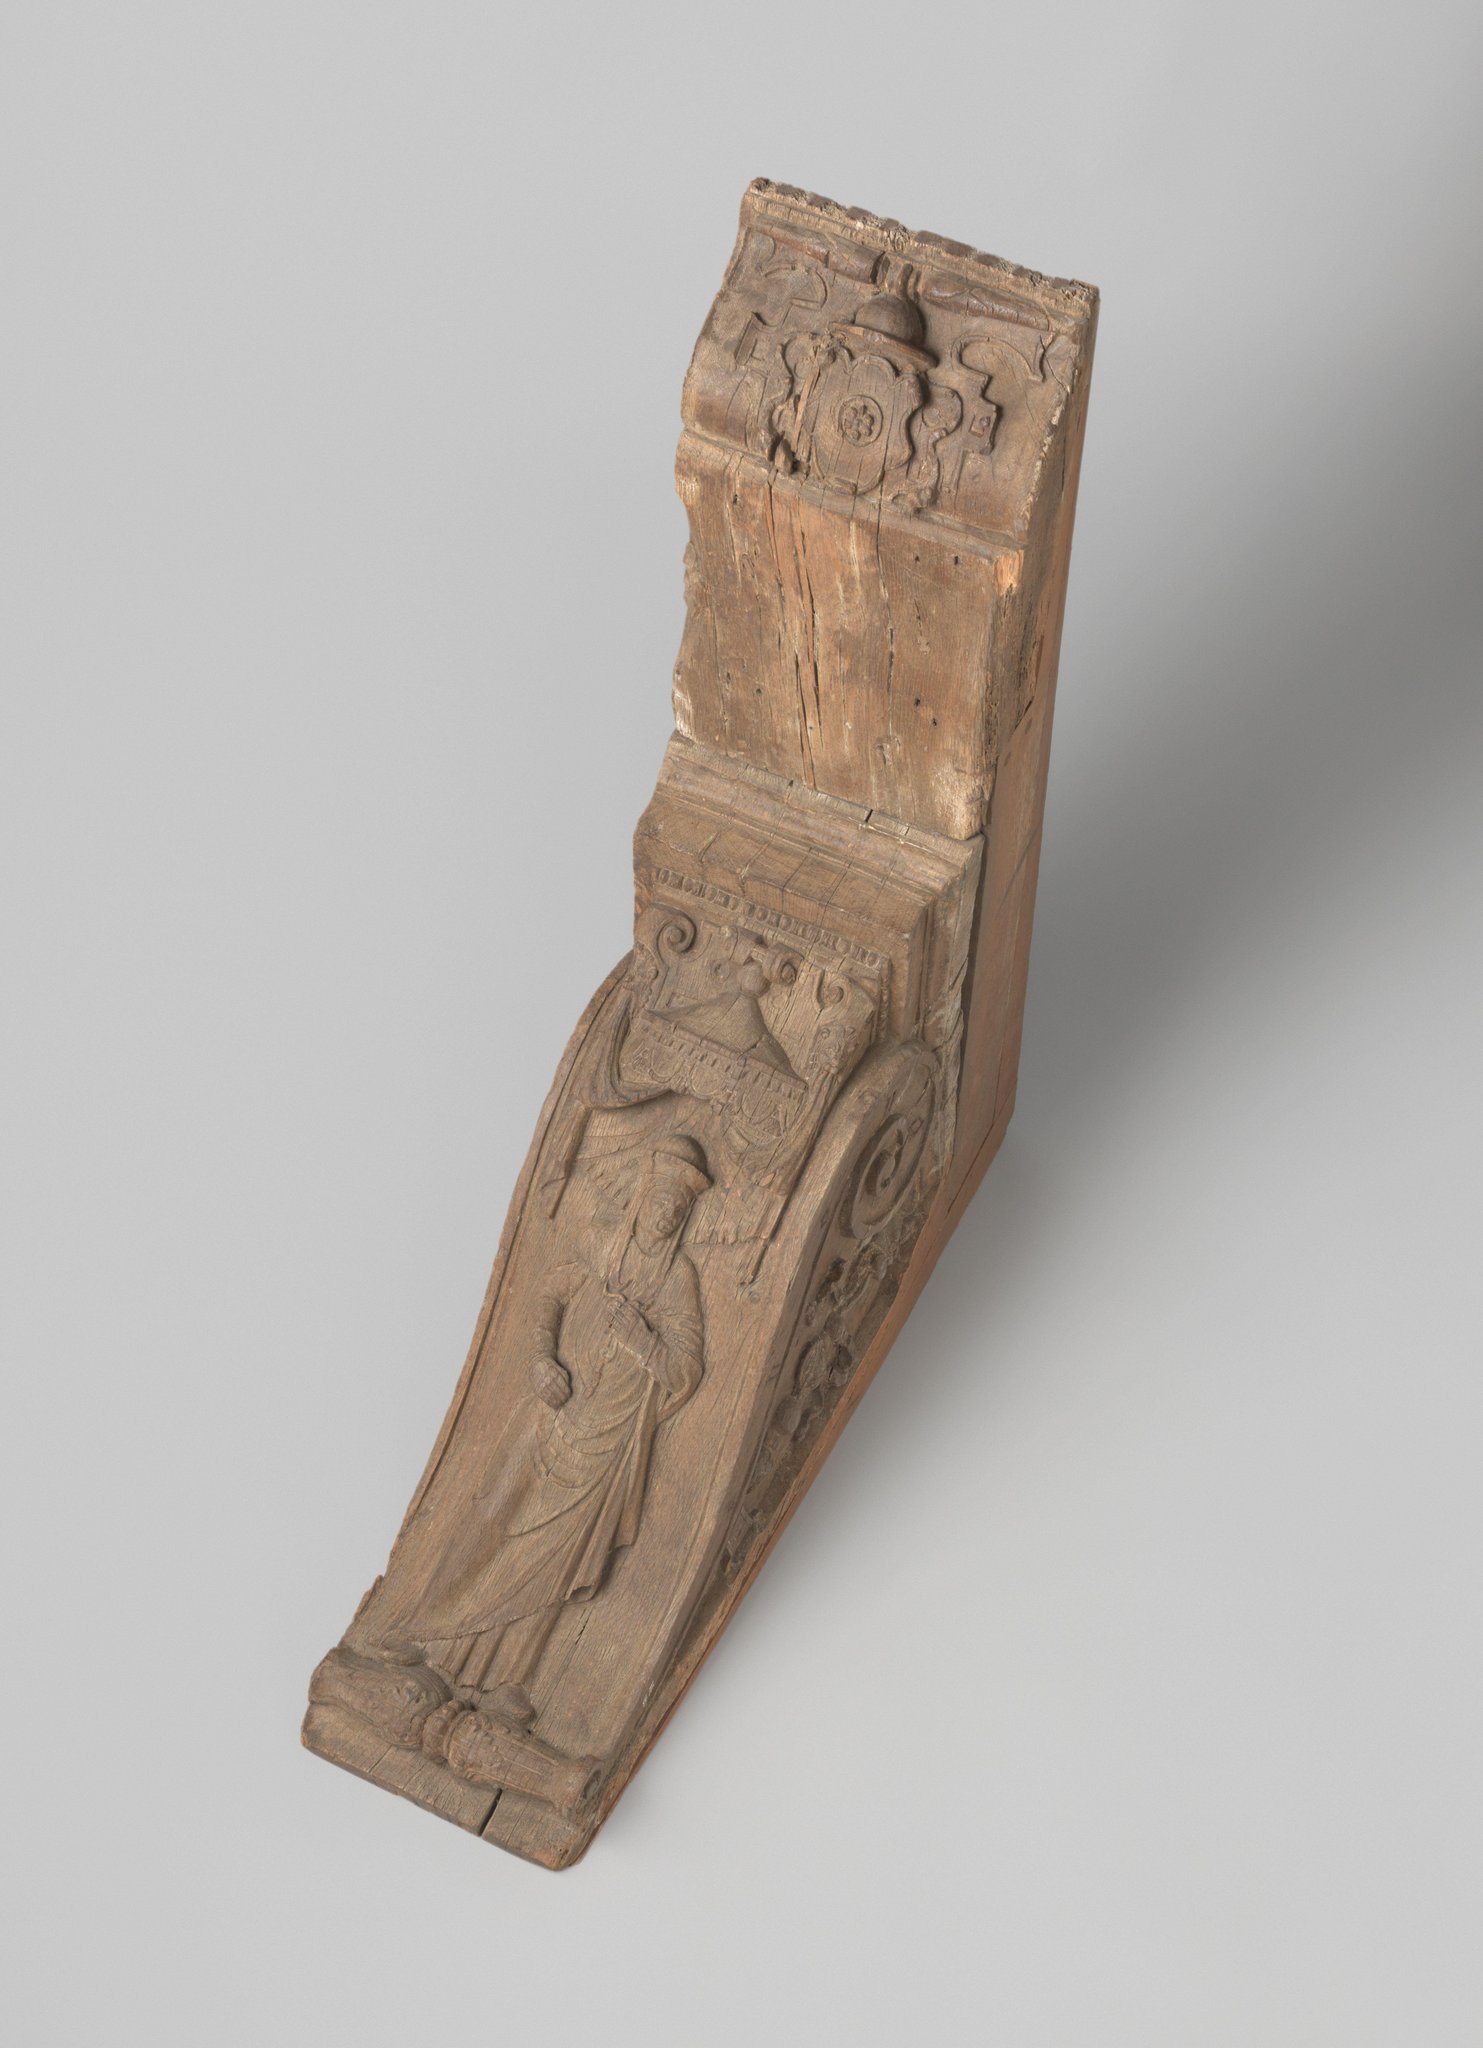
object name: architectural element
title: Sleutelstuk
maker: Anonymous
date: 1550-1600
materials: wood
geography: northern netherlands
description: Sleutelsuk van eikenhout, losgezaagd van een korbeel. Afkomstig uit het afgebroken huis Warmoesstraat 145 te Amsterdam.